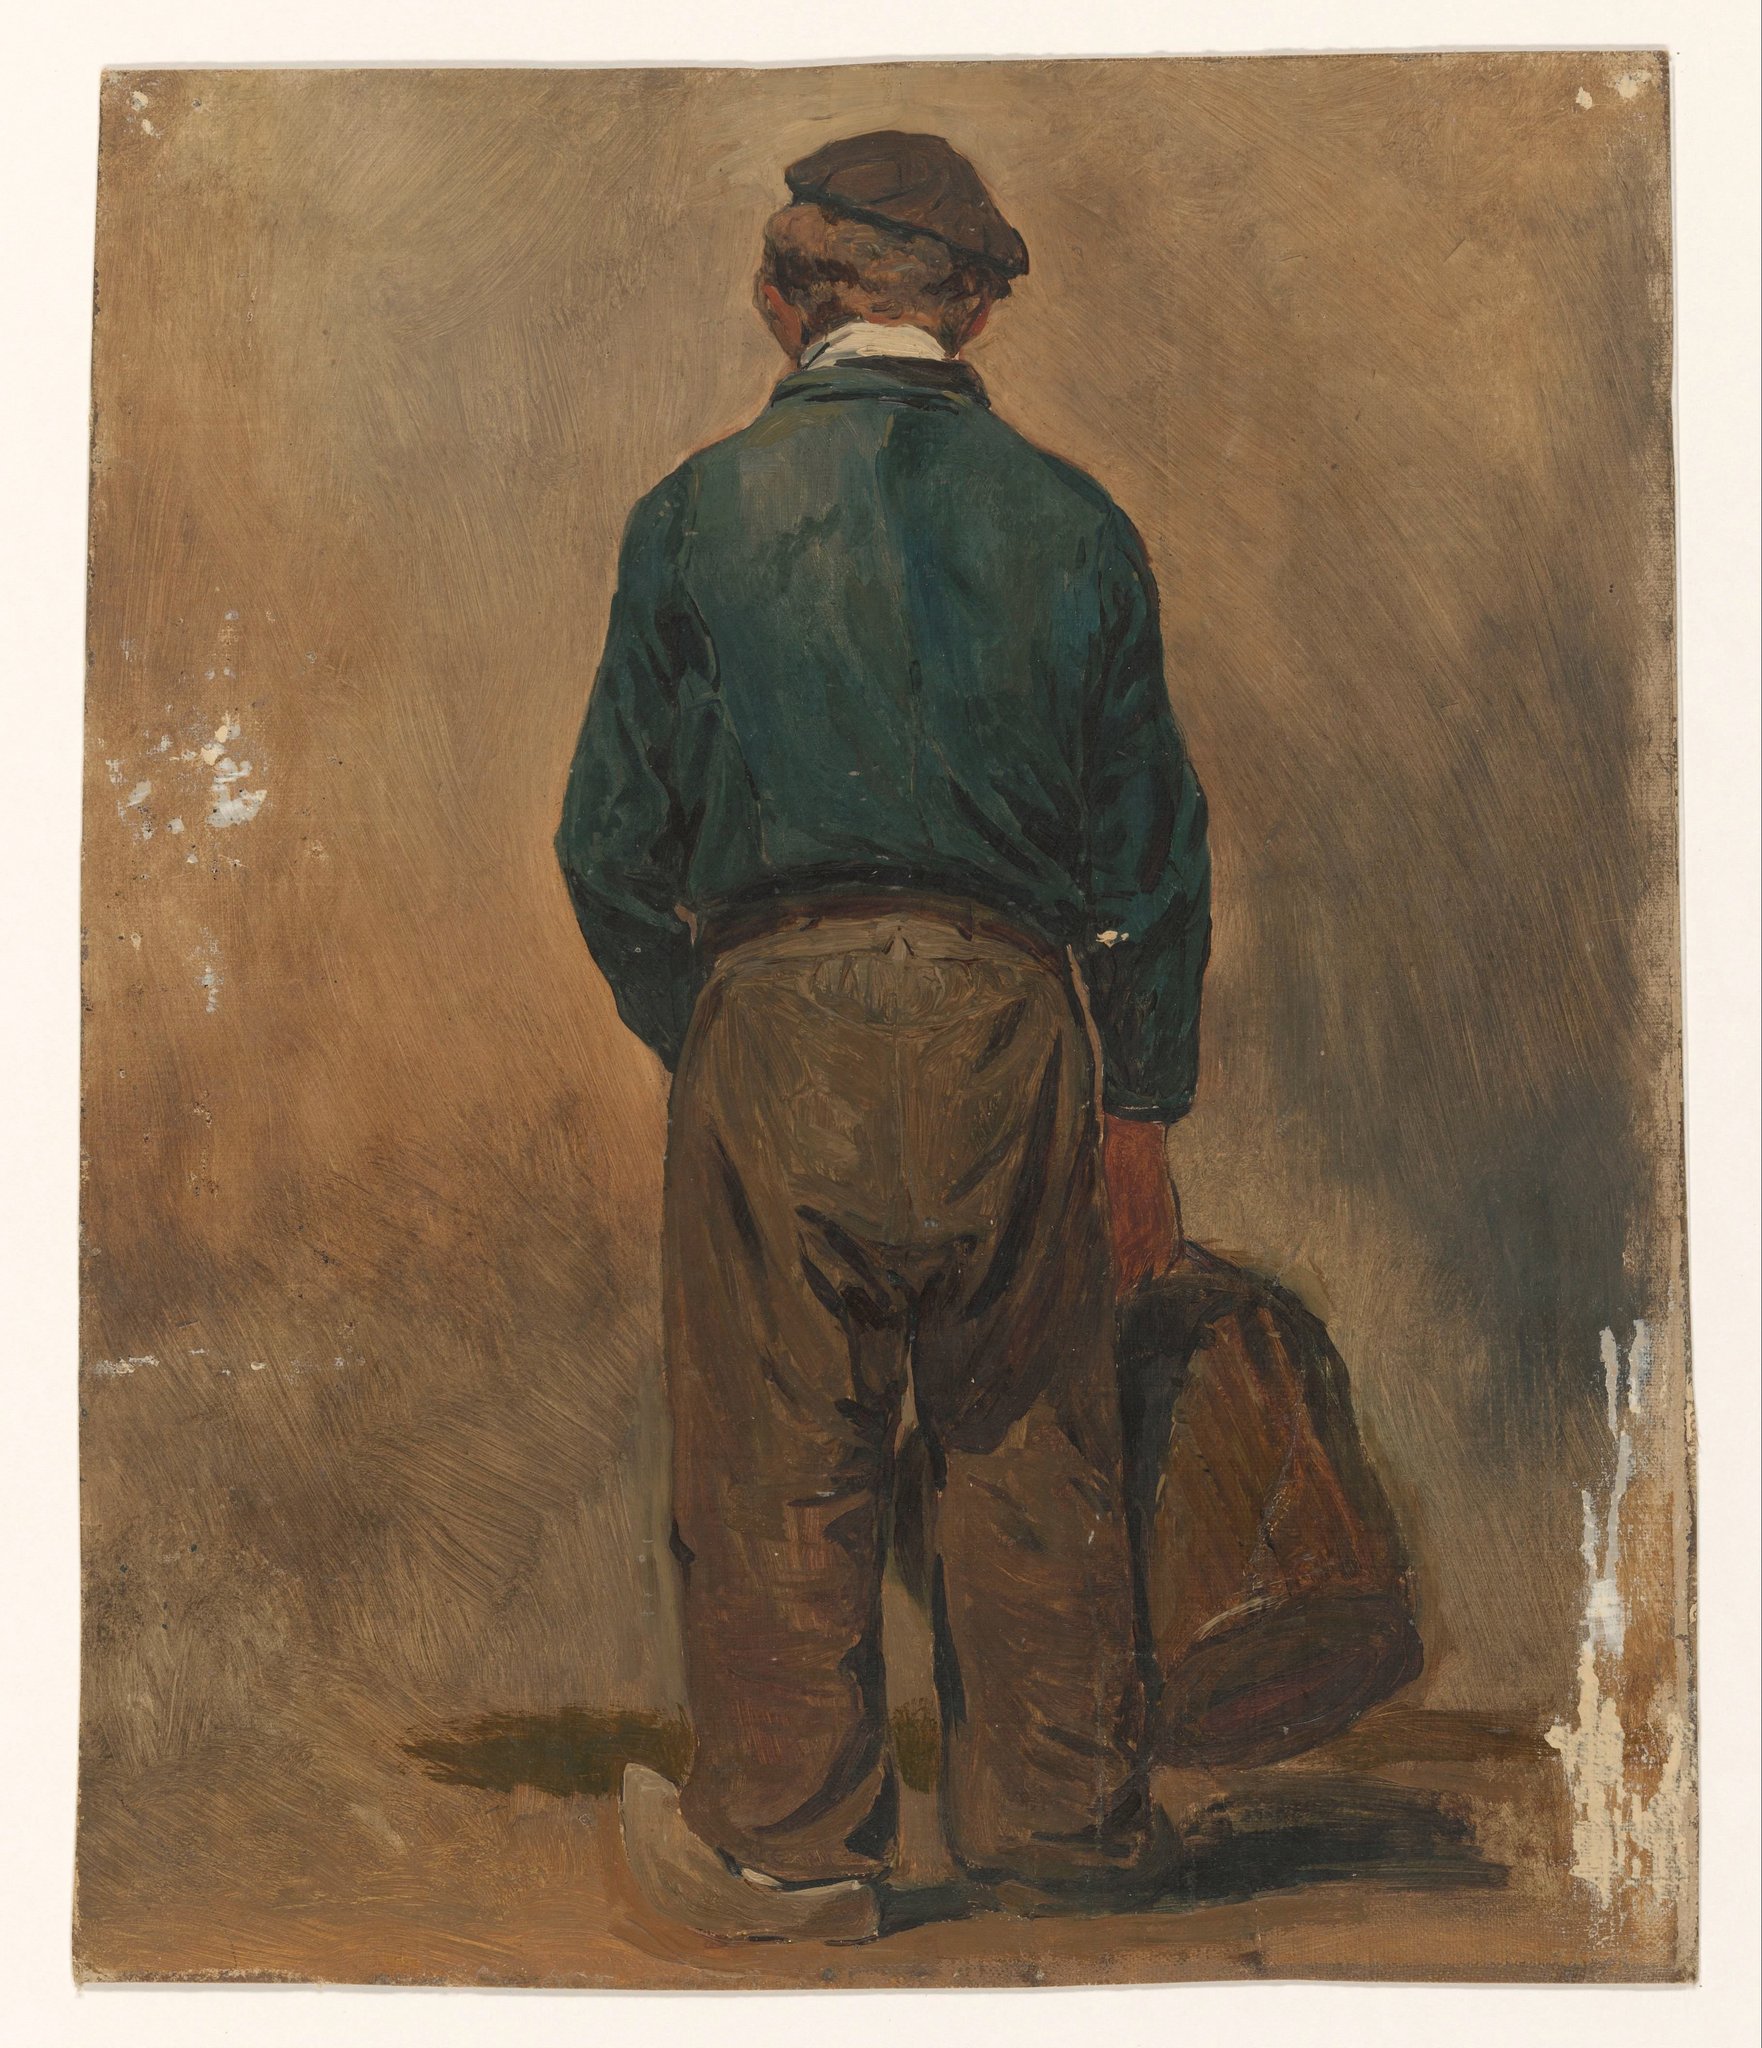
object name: painting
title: Visser met een mand, van achteren gezien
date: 1832-1880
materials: linen, oil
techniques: brush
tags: standing figure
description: Visser, met een mand in de hand, van achteren gezien.